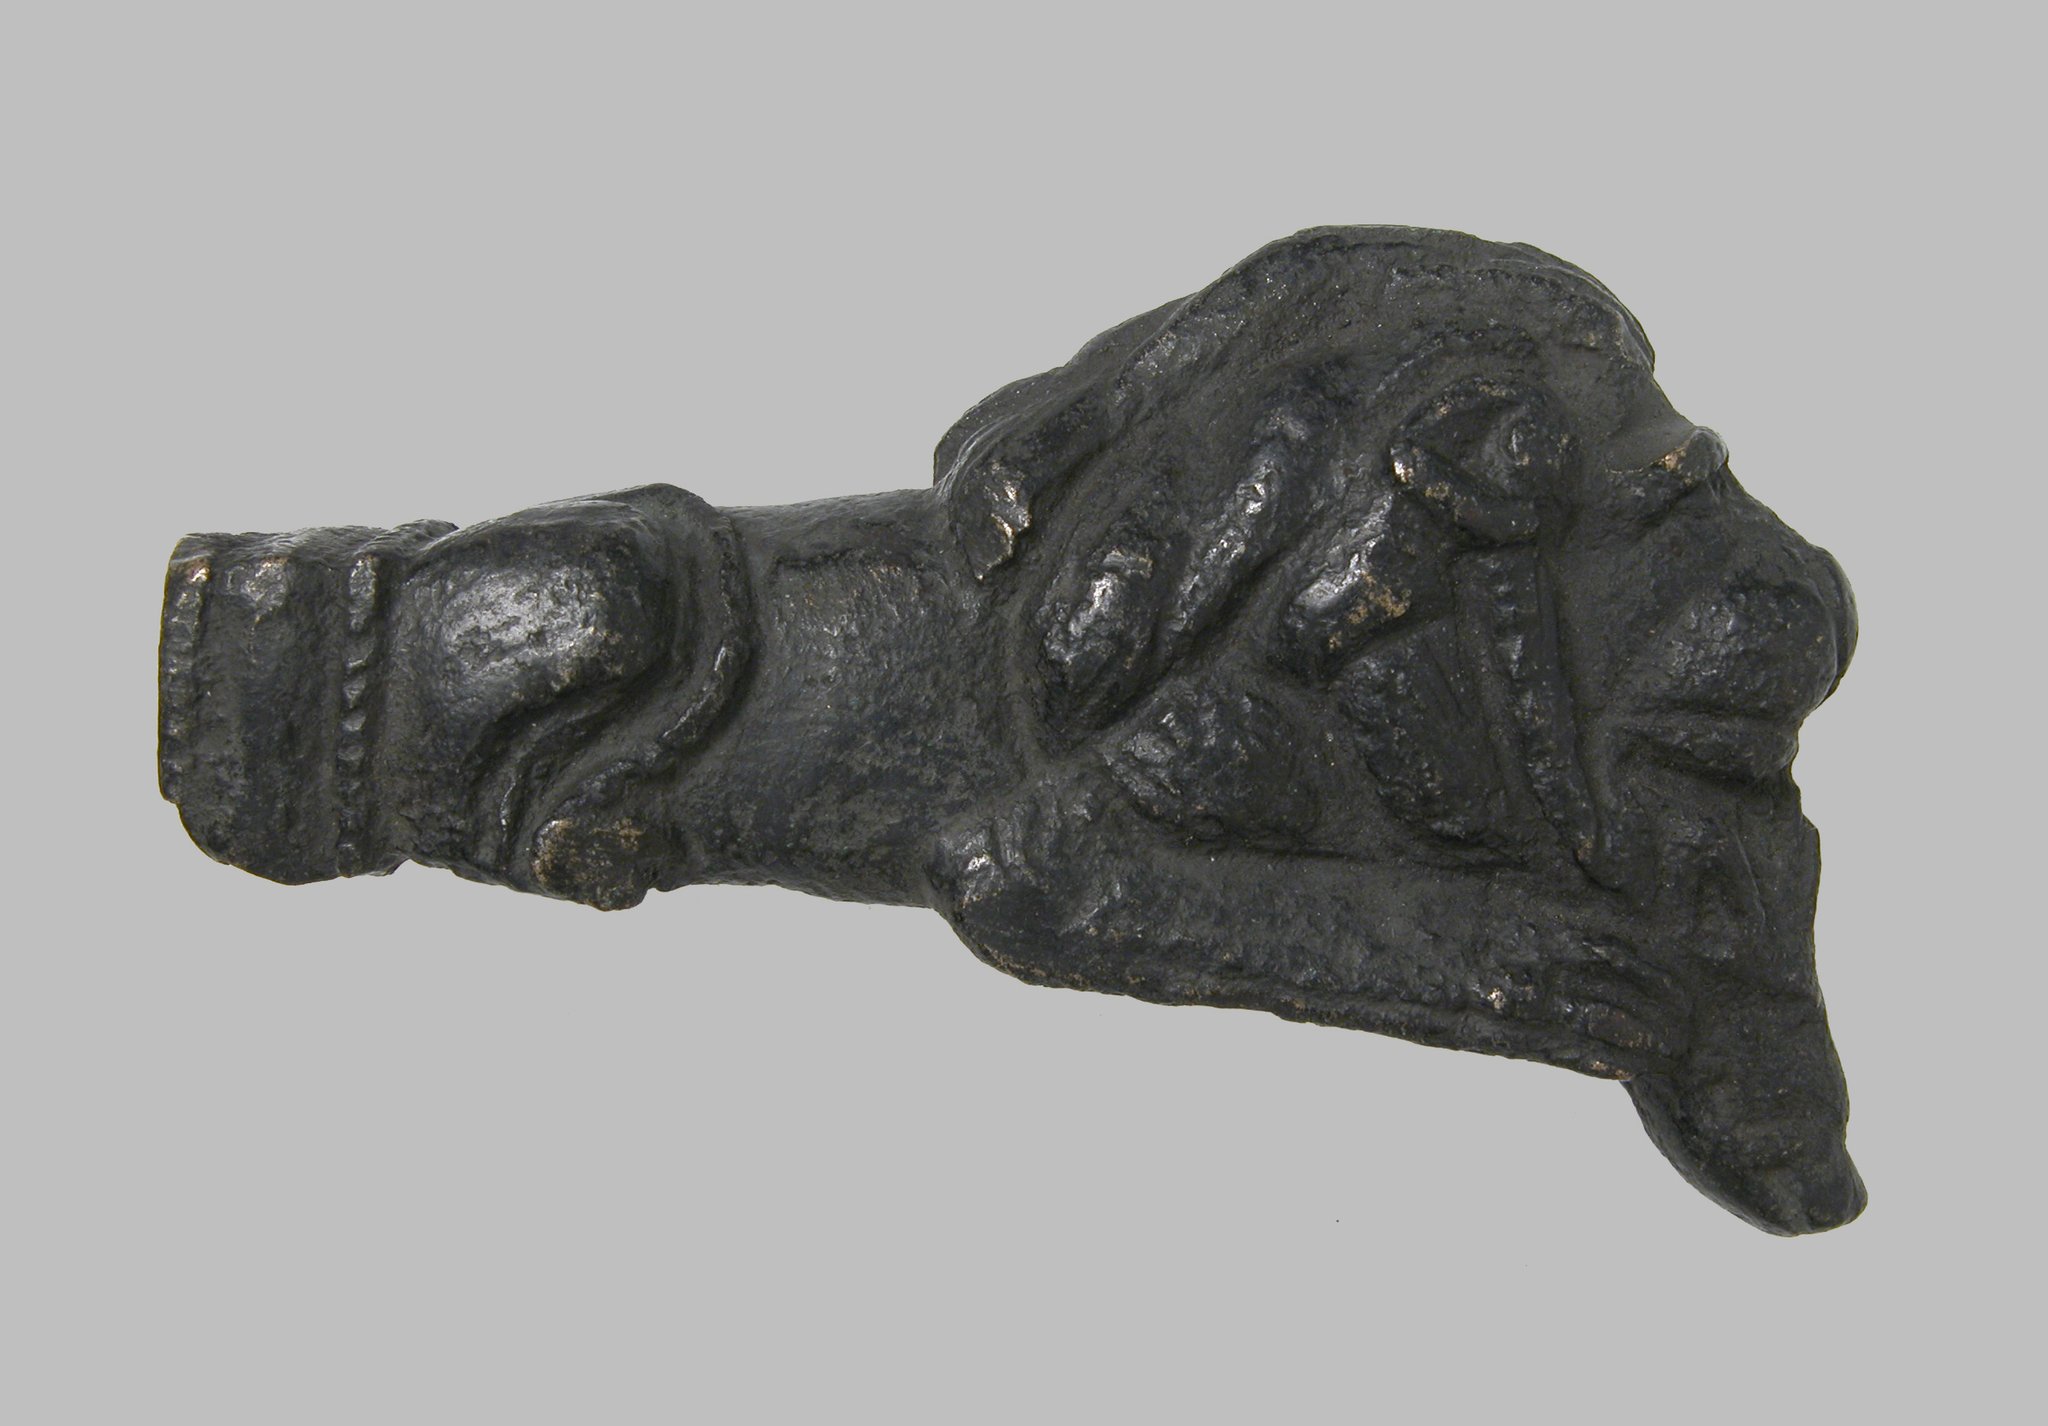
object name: key handle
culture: roman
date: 1-700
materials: copper alloy